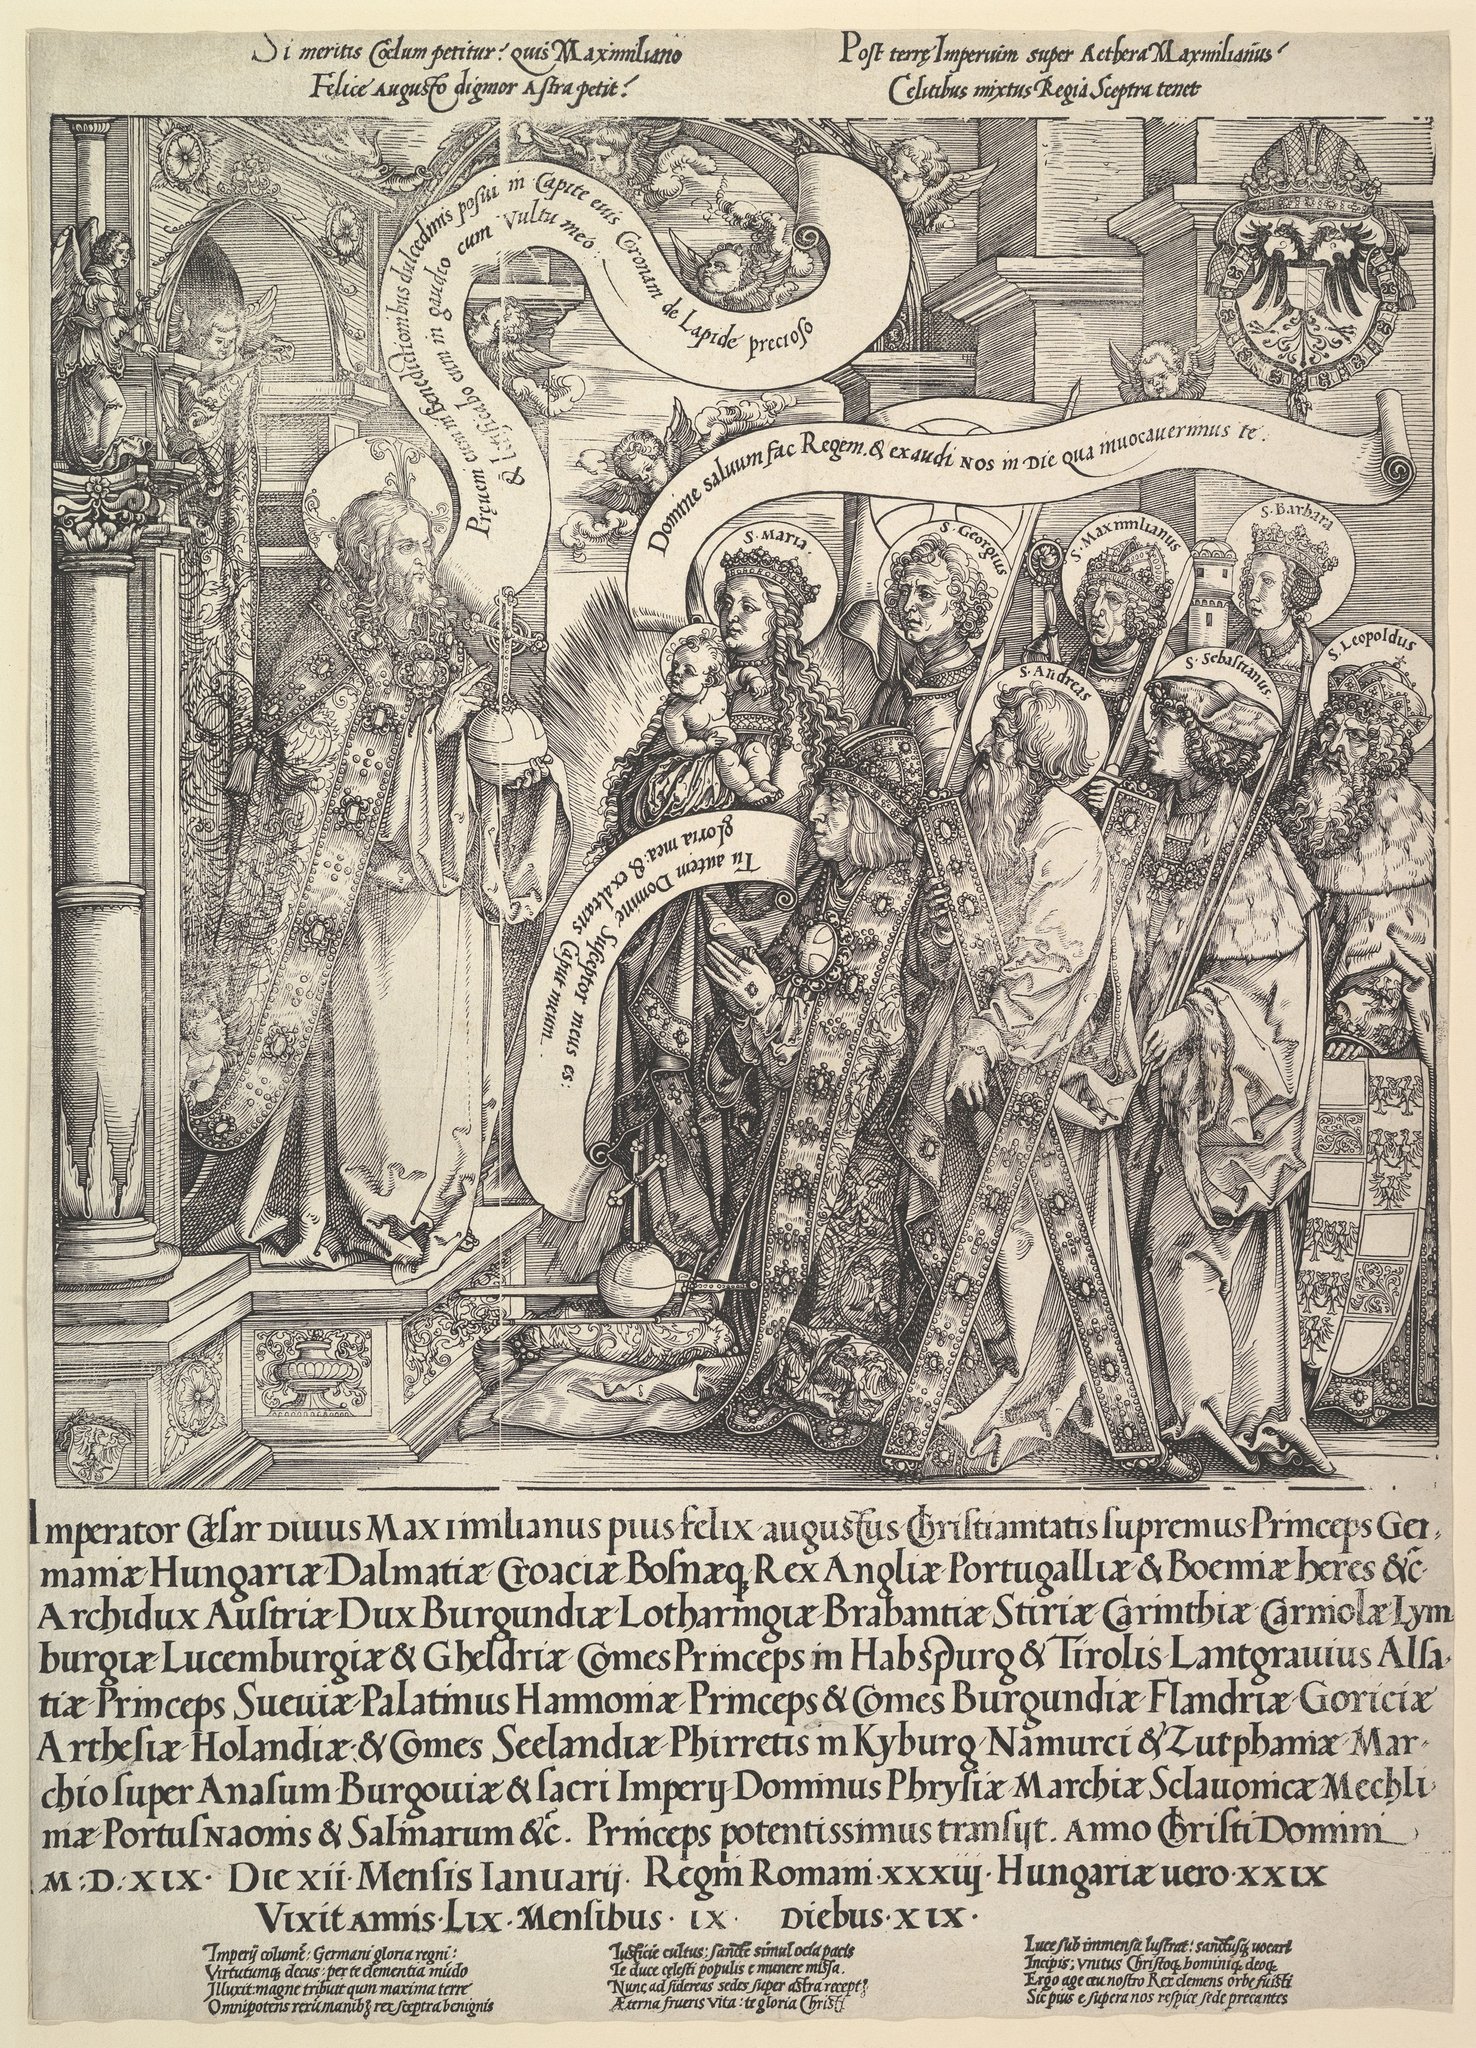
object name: print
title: Maximilian Presented by his Patron Saints to the Almighty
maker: hans springinklee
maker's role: artist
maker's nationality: german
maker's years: 1495-1530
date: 1519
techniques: woodcut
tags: kings,saints